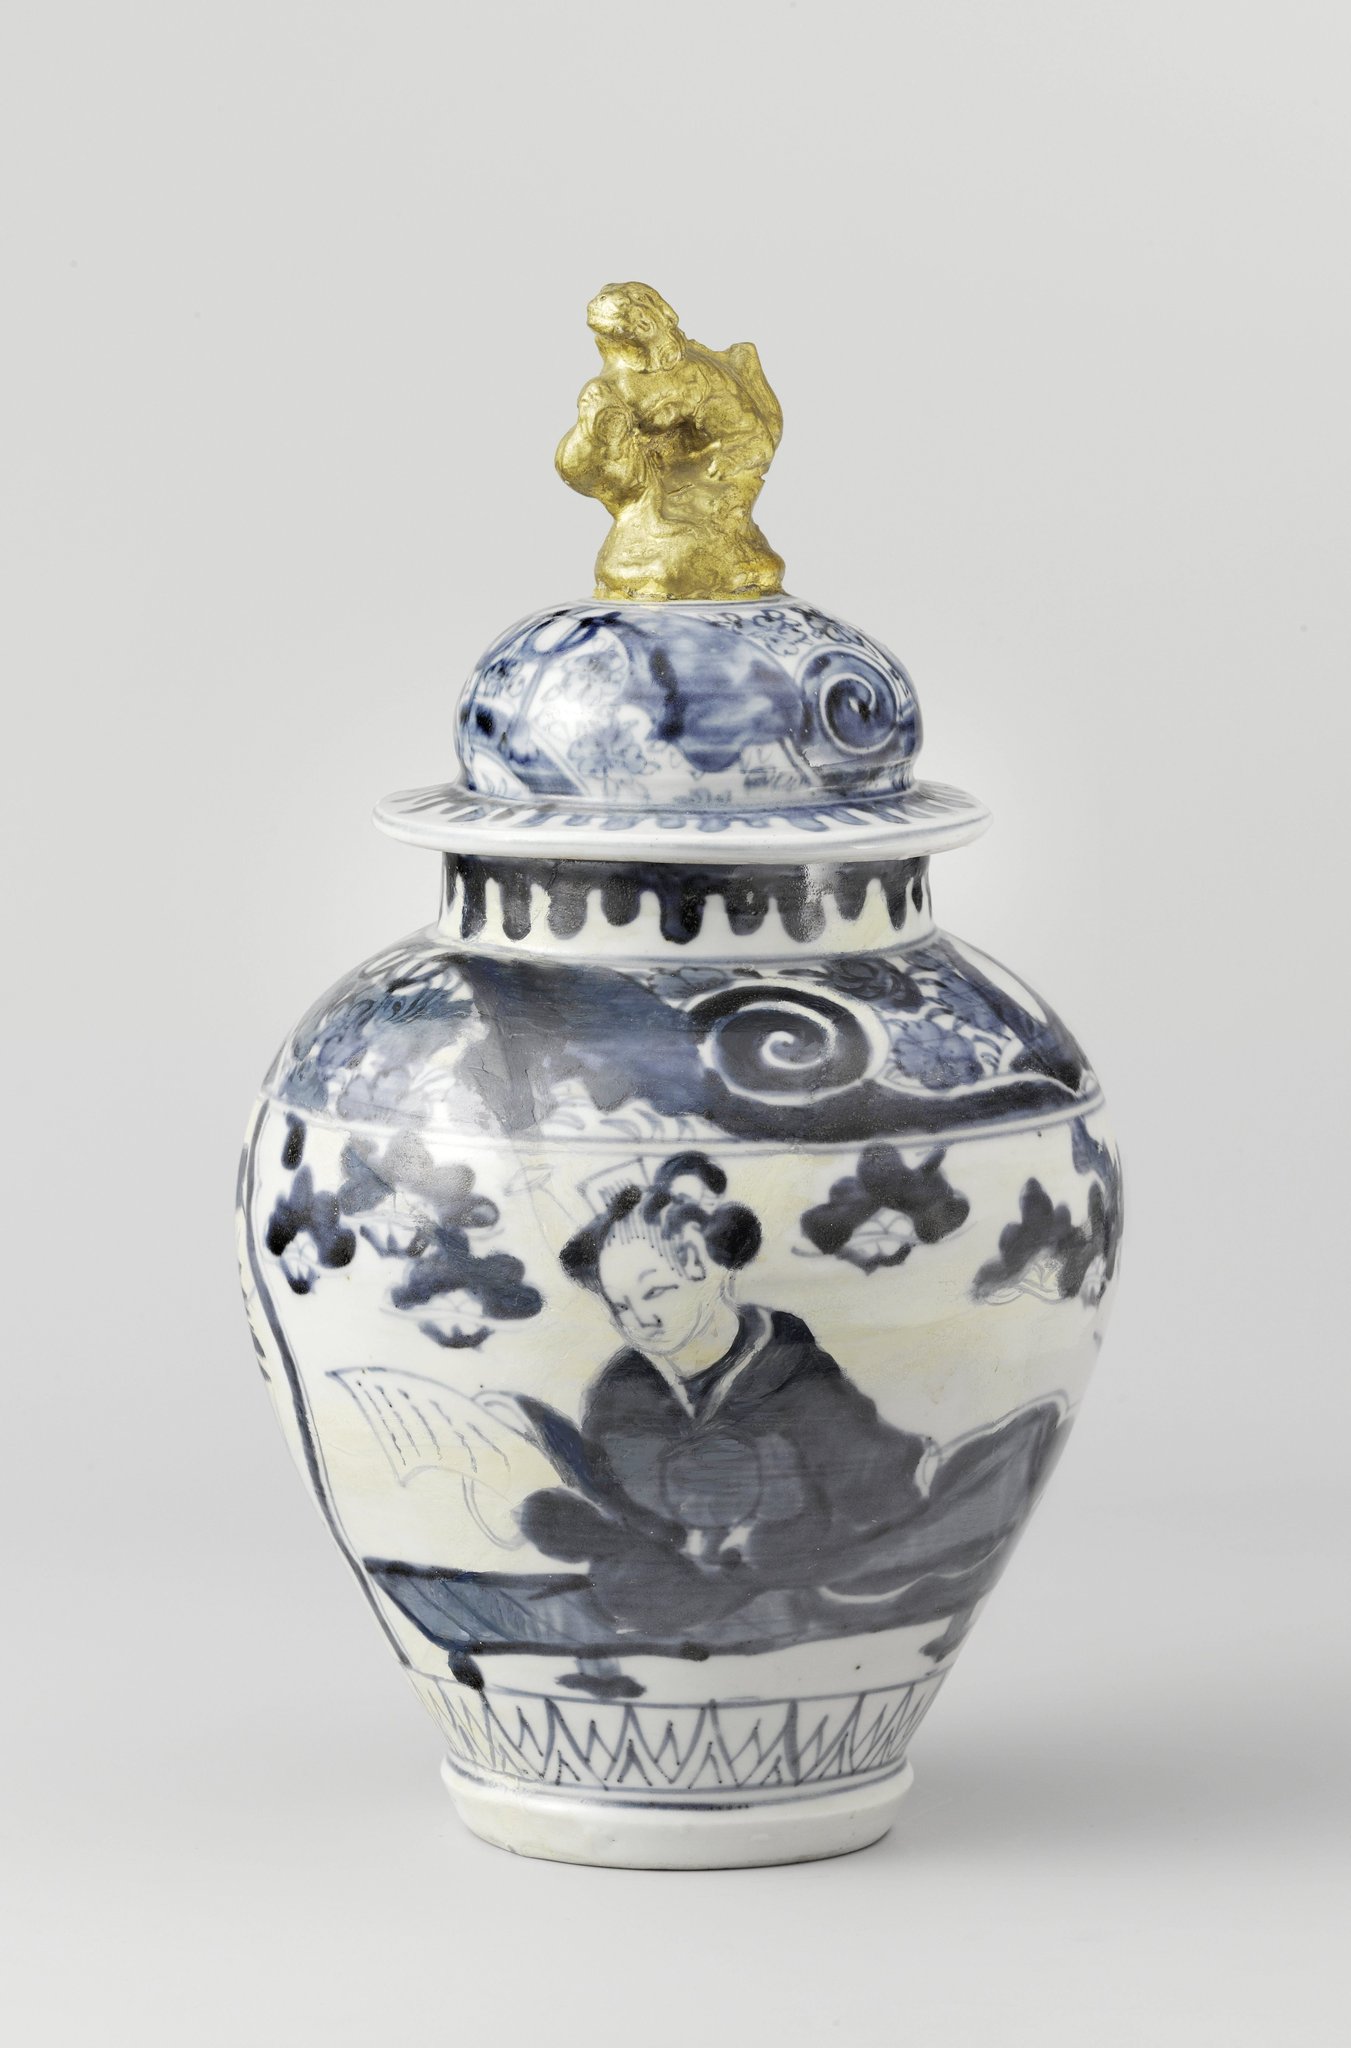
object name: covered jar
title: Ovoid covered jar with a woman reading a letter and finial in the shape of a shishi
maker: Anonymous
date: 1650-1699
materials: cobalt, glaze, gold, paint, porcelain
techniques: firing, gilding, turning, vitrification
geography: japan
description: Eivormige dekselpot van porselein, beschilderd in onderglazuurblauw en op het glazuur goud. Op de buik twee vakken met in één een zittende vrouw met een brief in haar hand, de ander met twee bloeiende bomen bij rotsen en een hek. Op de schouder een band met spriralen en prunusbloemen. Rond de voet een band met puntige bladmotieven. De hals met een decoratieve band. De deksel met dezelfde decoratie als de schouder; dekselknop in de vorm van een shishi (leeuwhond) op een rots, bedekt met goudverf. Pot is gebroken geweest, dekselknop is afgebroken geweest. Arita, blauw-wit.